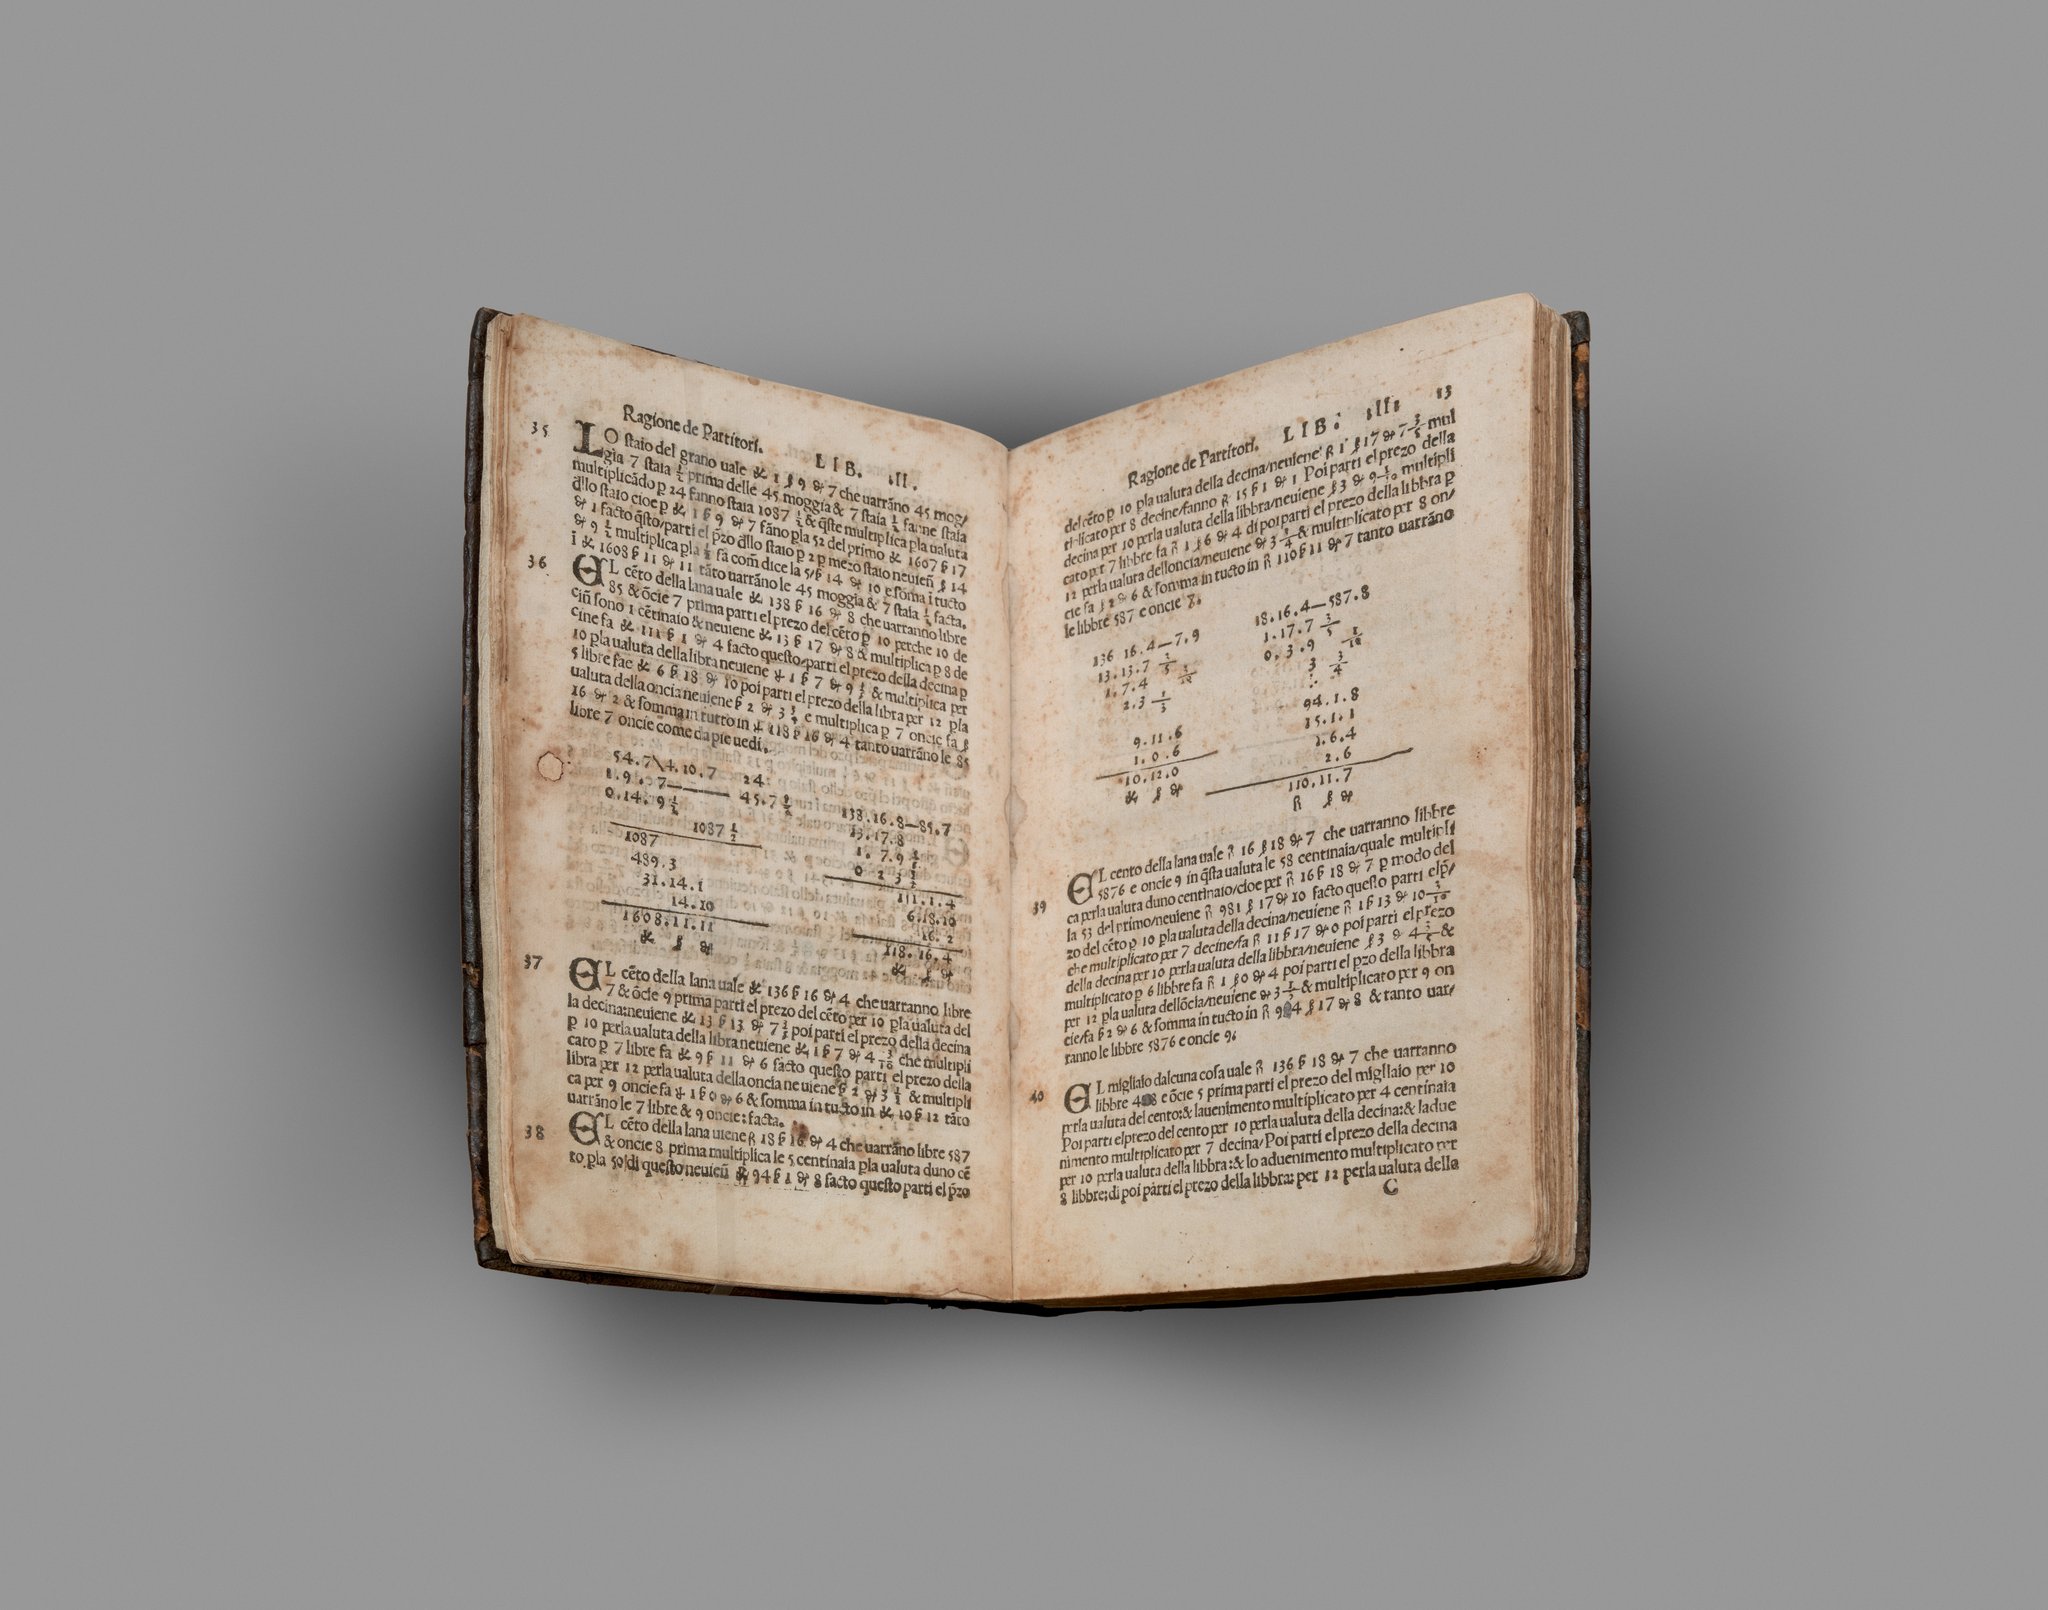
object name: book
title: Summa de Arithmetica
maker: francisco di lionardo ghaligaio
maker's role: author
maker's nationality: italian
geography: italy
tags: mathematics